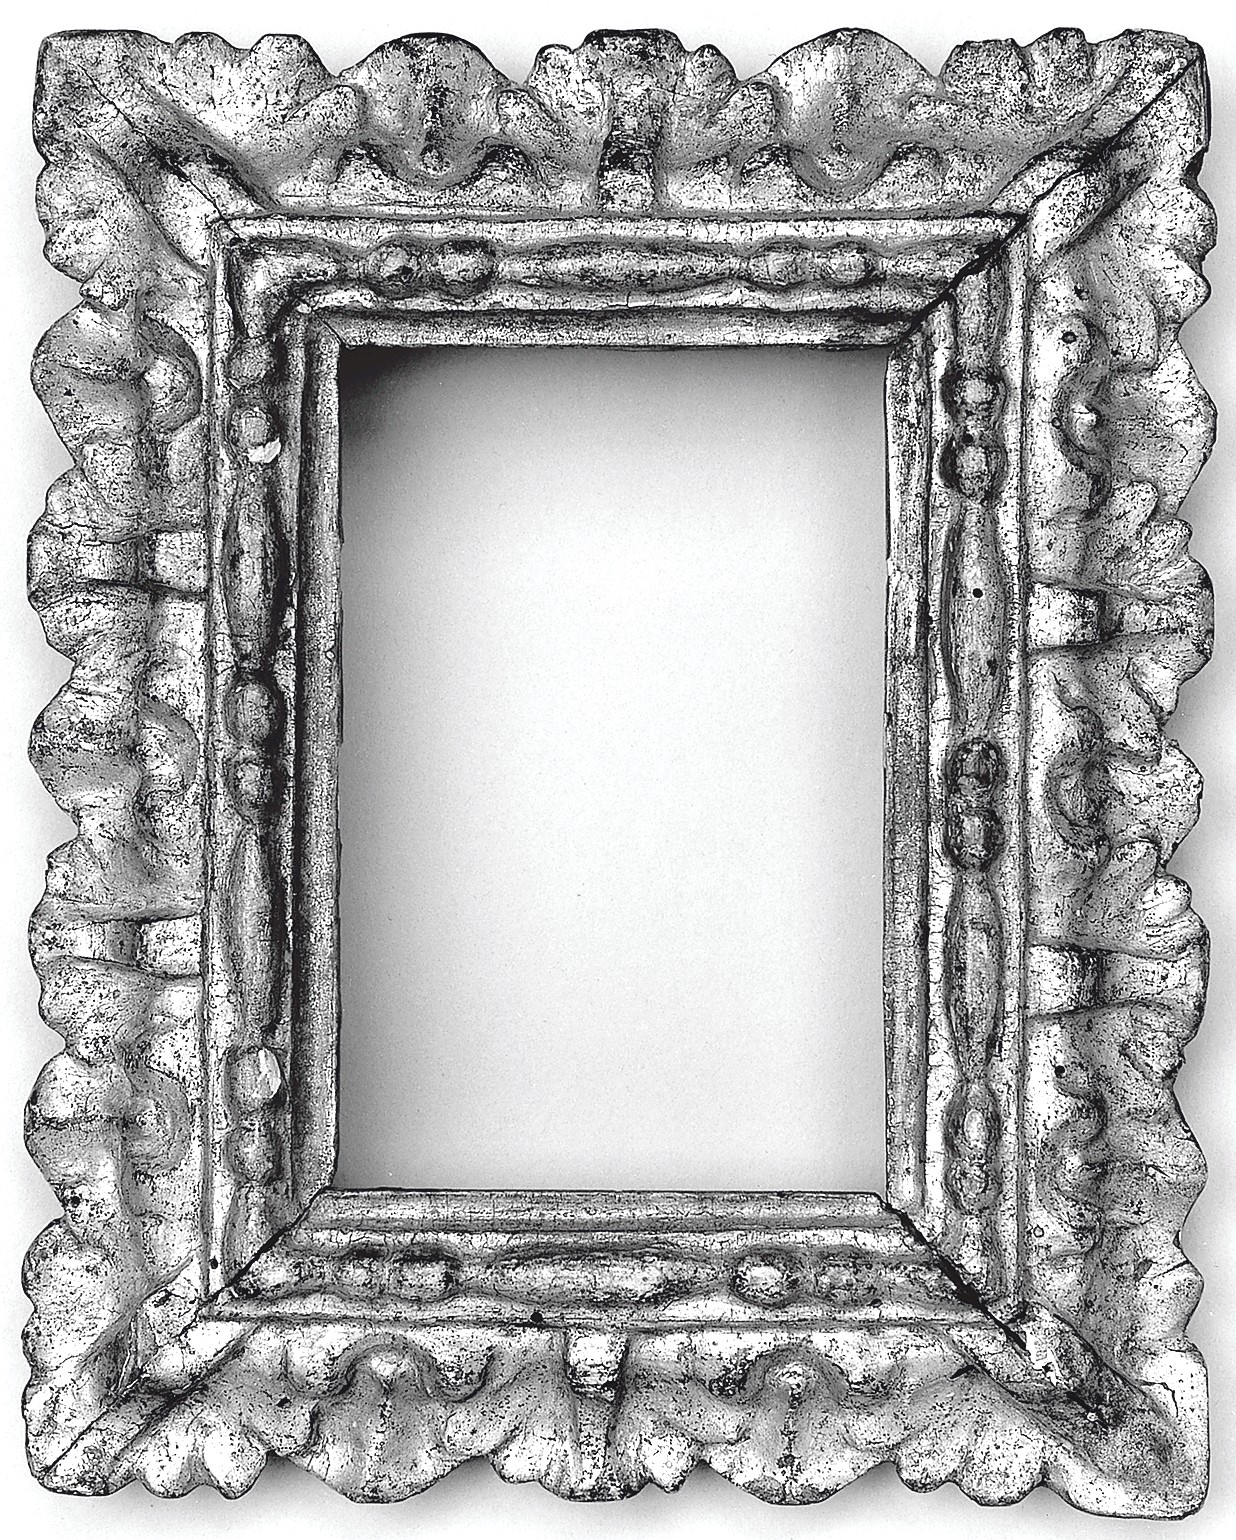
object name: frame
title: Reverse frame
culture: italian, veneto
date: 1634-1666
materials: wood